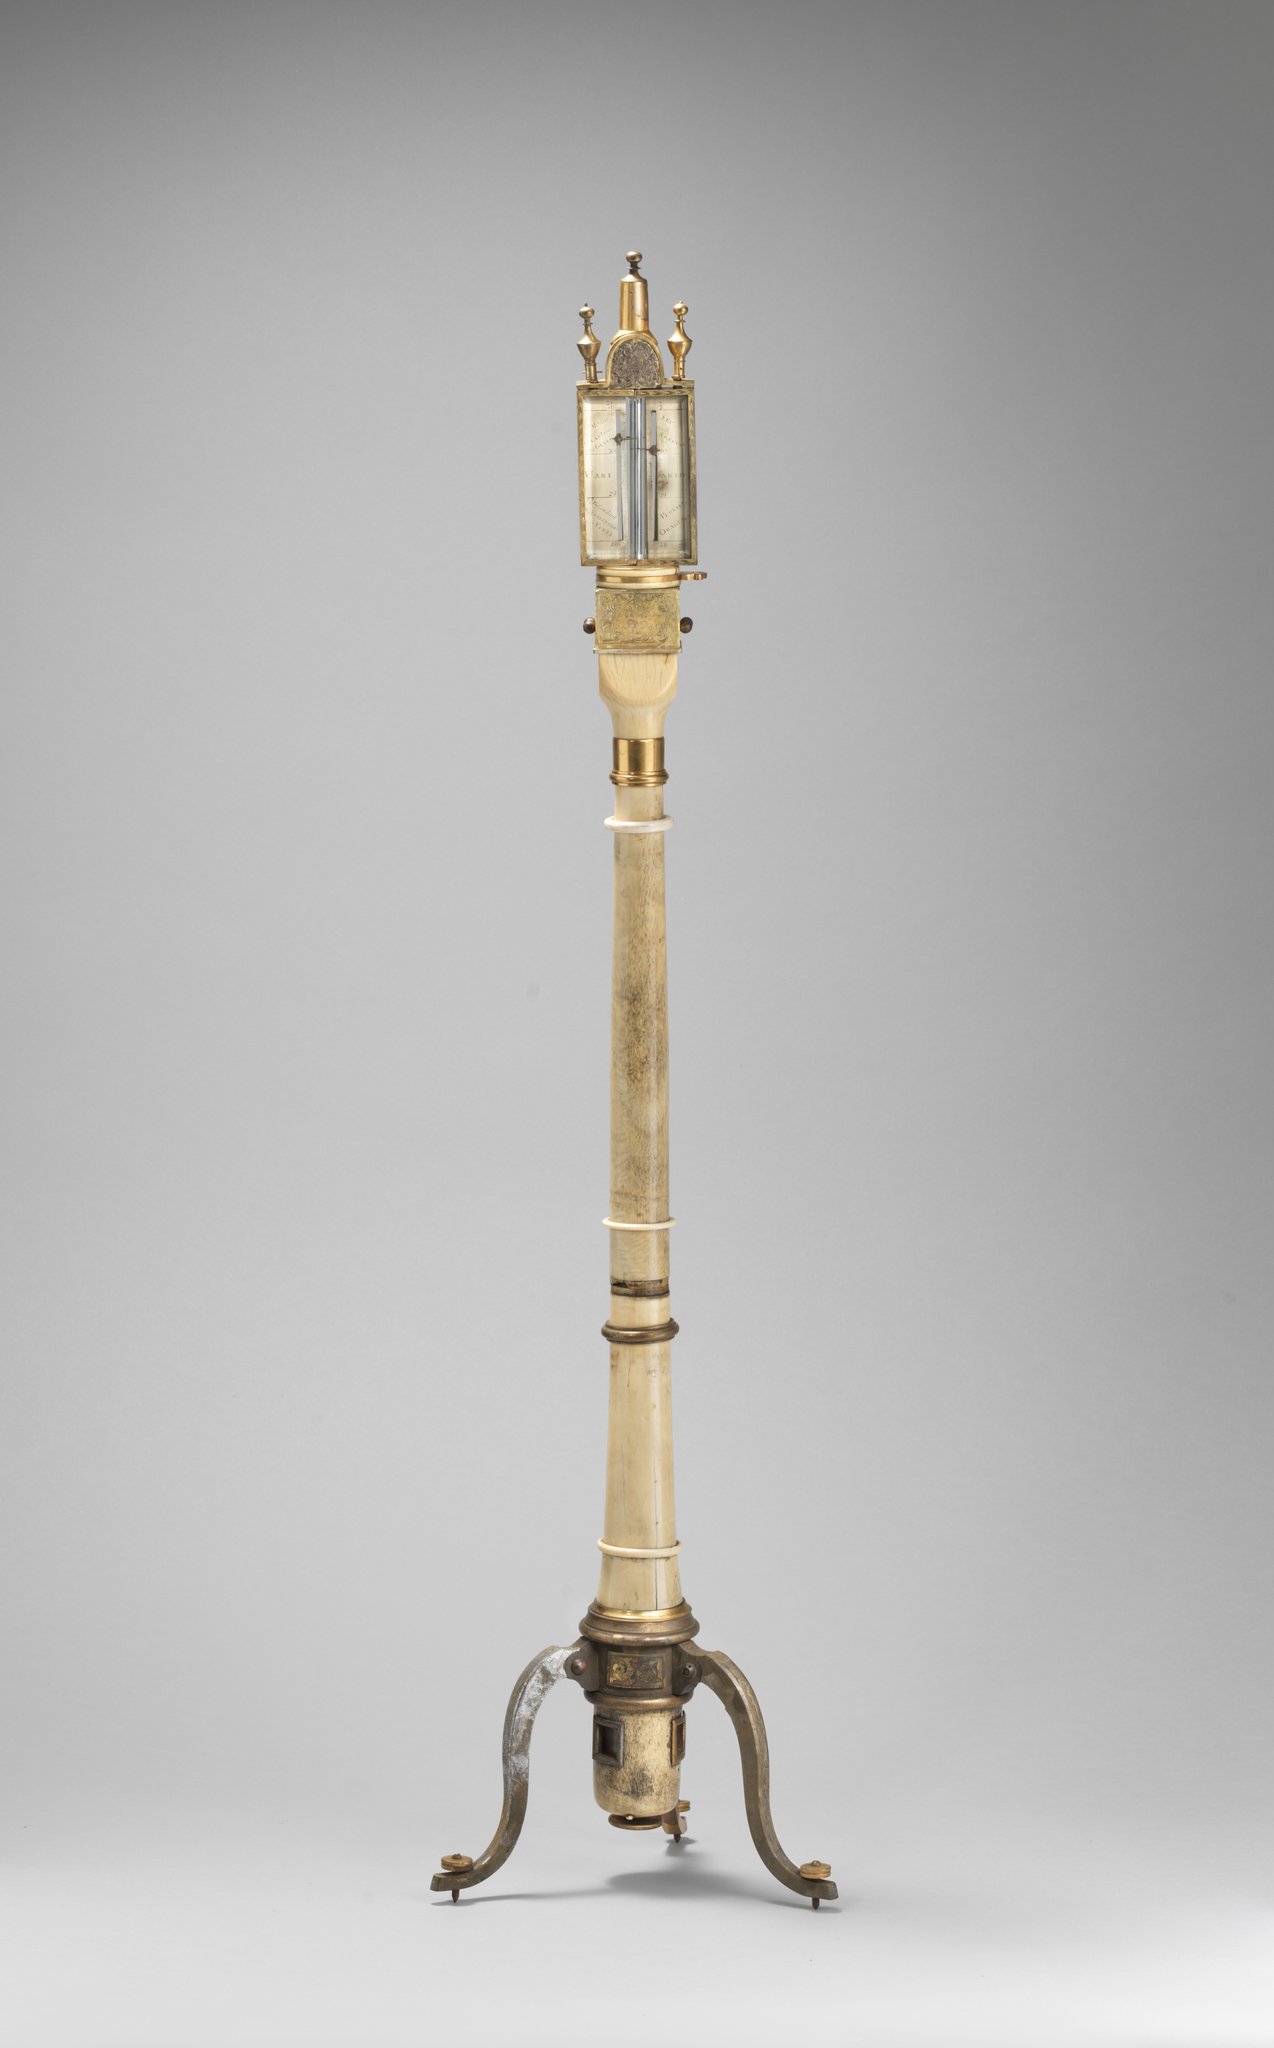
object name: portable barometer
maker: daniel quare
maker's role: maker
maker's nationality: british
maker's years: 1647-1724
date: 1695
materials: gilt bronze, ivory, mercury